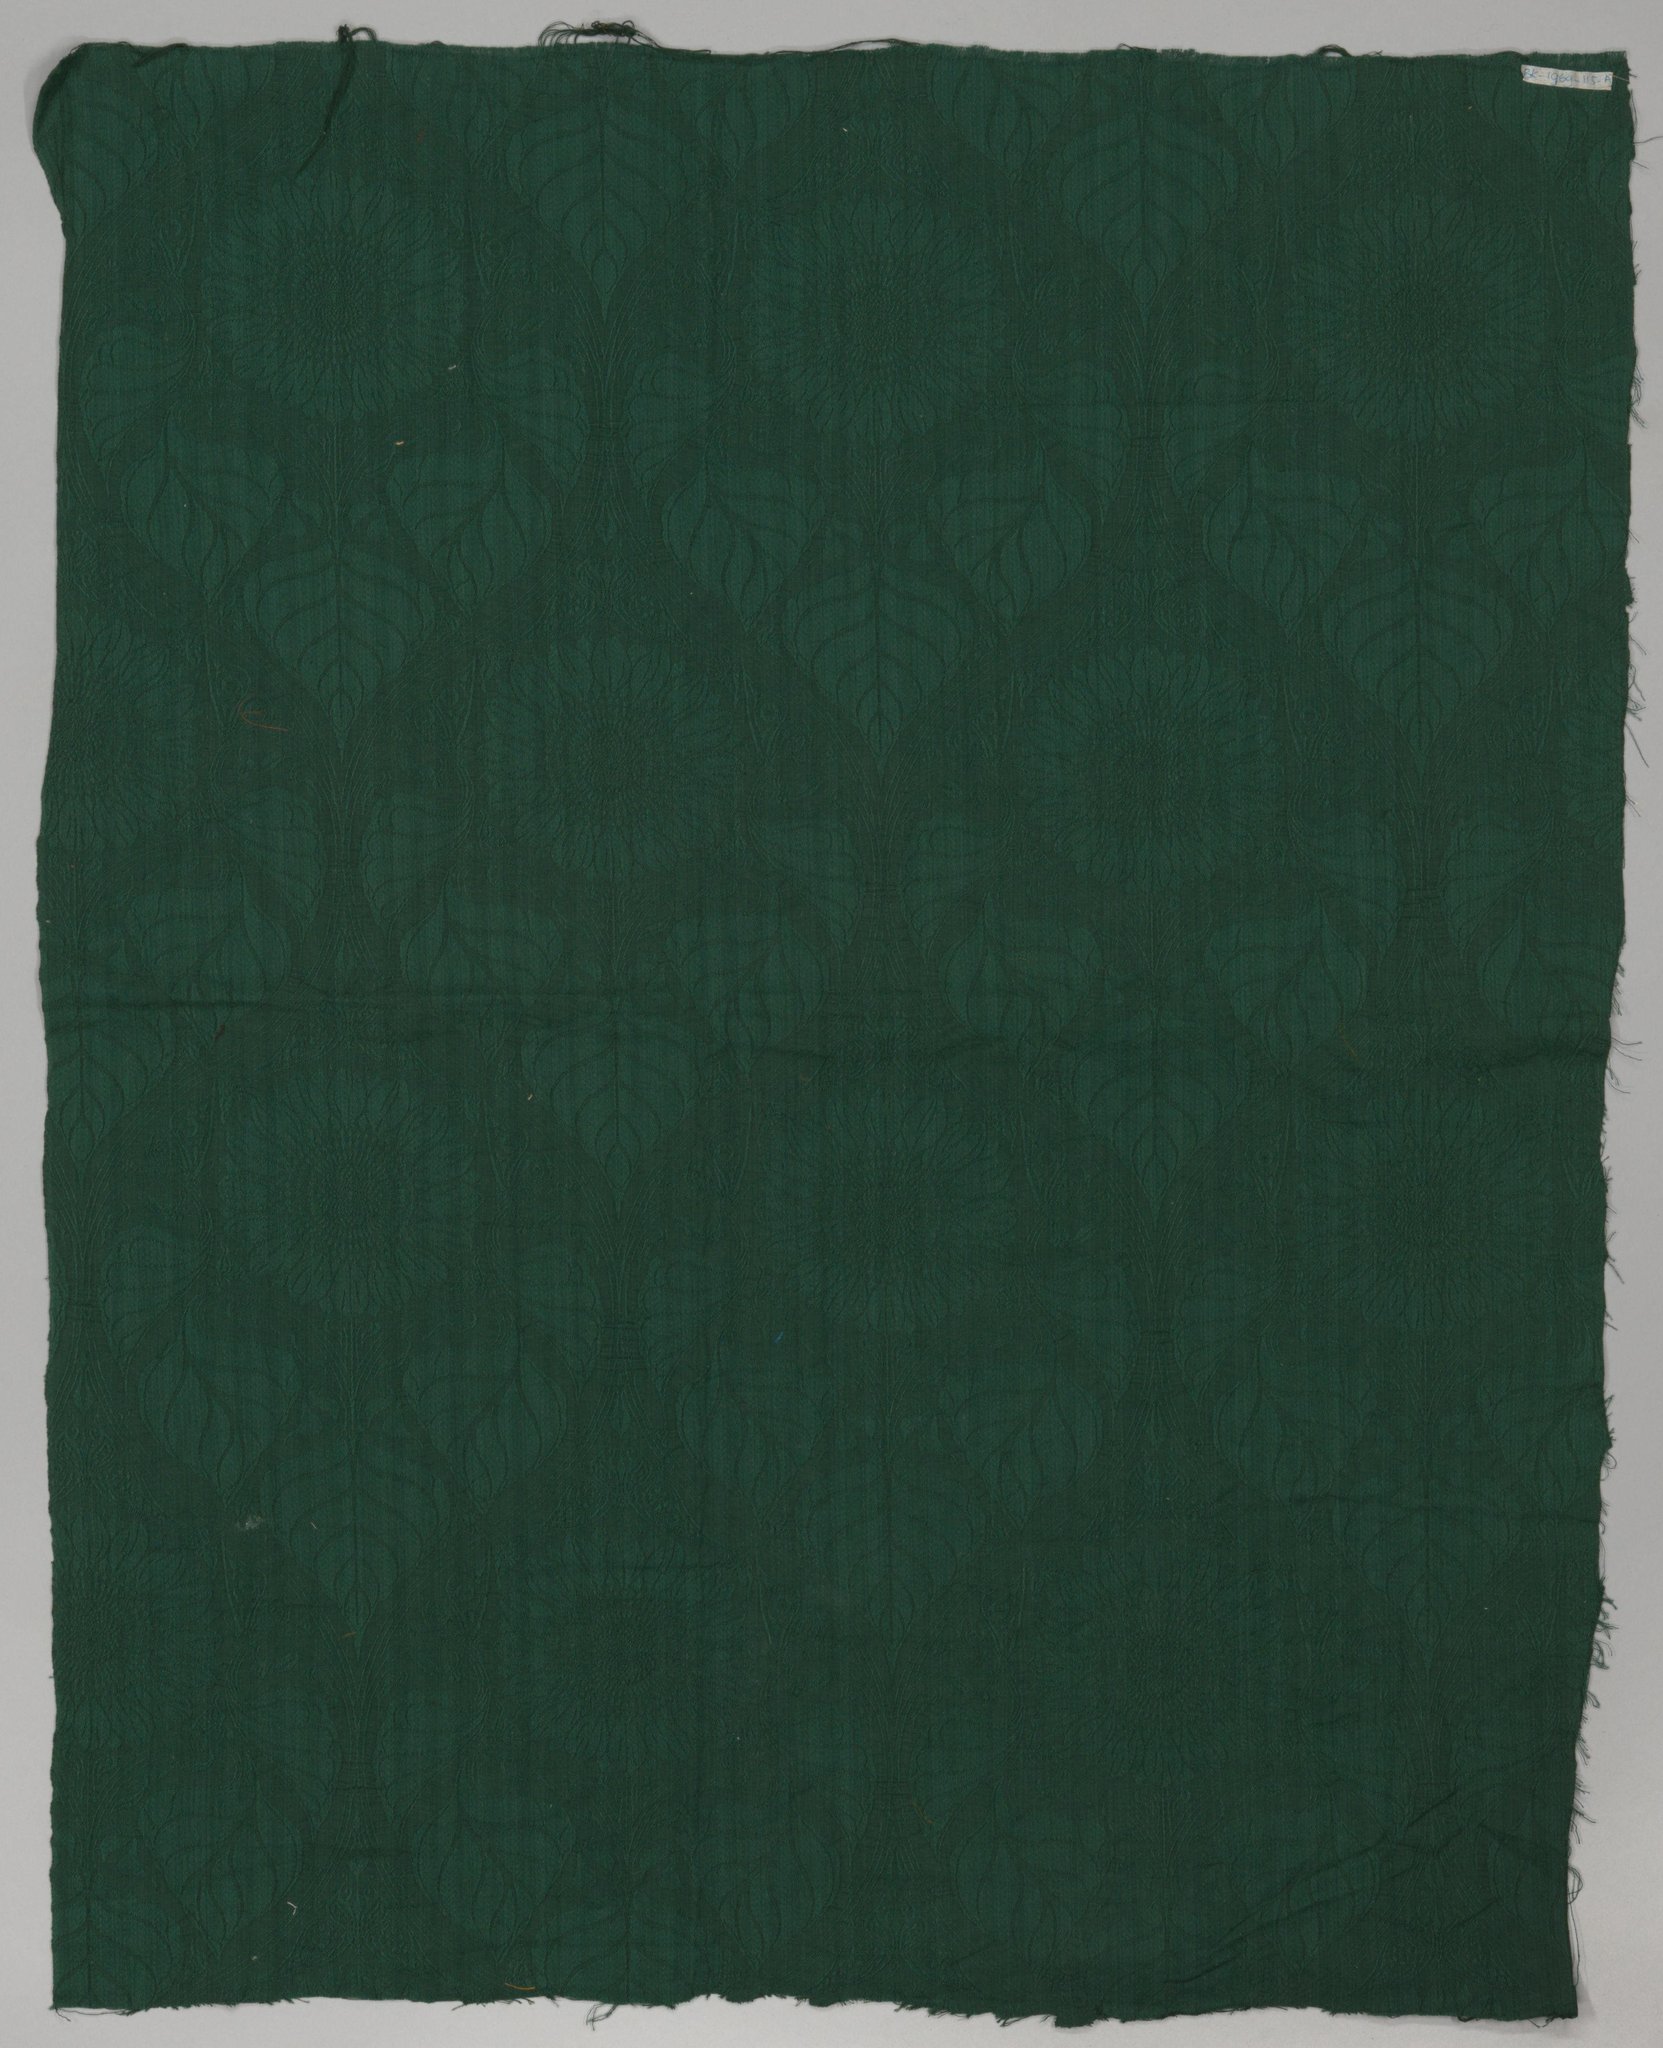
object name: upholstery fabric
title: Fragment van bespanningsstof met patroon van zonnebloem en vlinders binnen spitsovalen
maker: theo nieuwenhuis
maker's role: designer, draughtsman, print maker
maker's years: 1866-1951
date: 1909-1924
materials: cotton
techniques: jacquard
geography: netherlands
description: Fragment van bespanningsstof met patroon van zonnebloem en vlinders binnen spitsovalen. Donkergroene inslag op iets lichtere groene ketting.